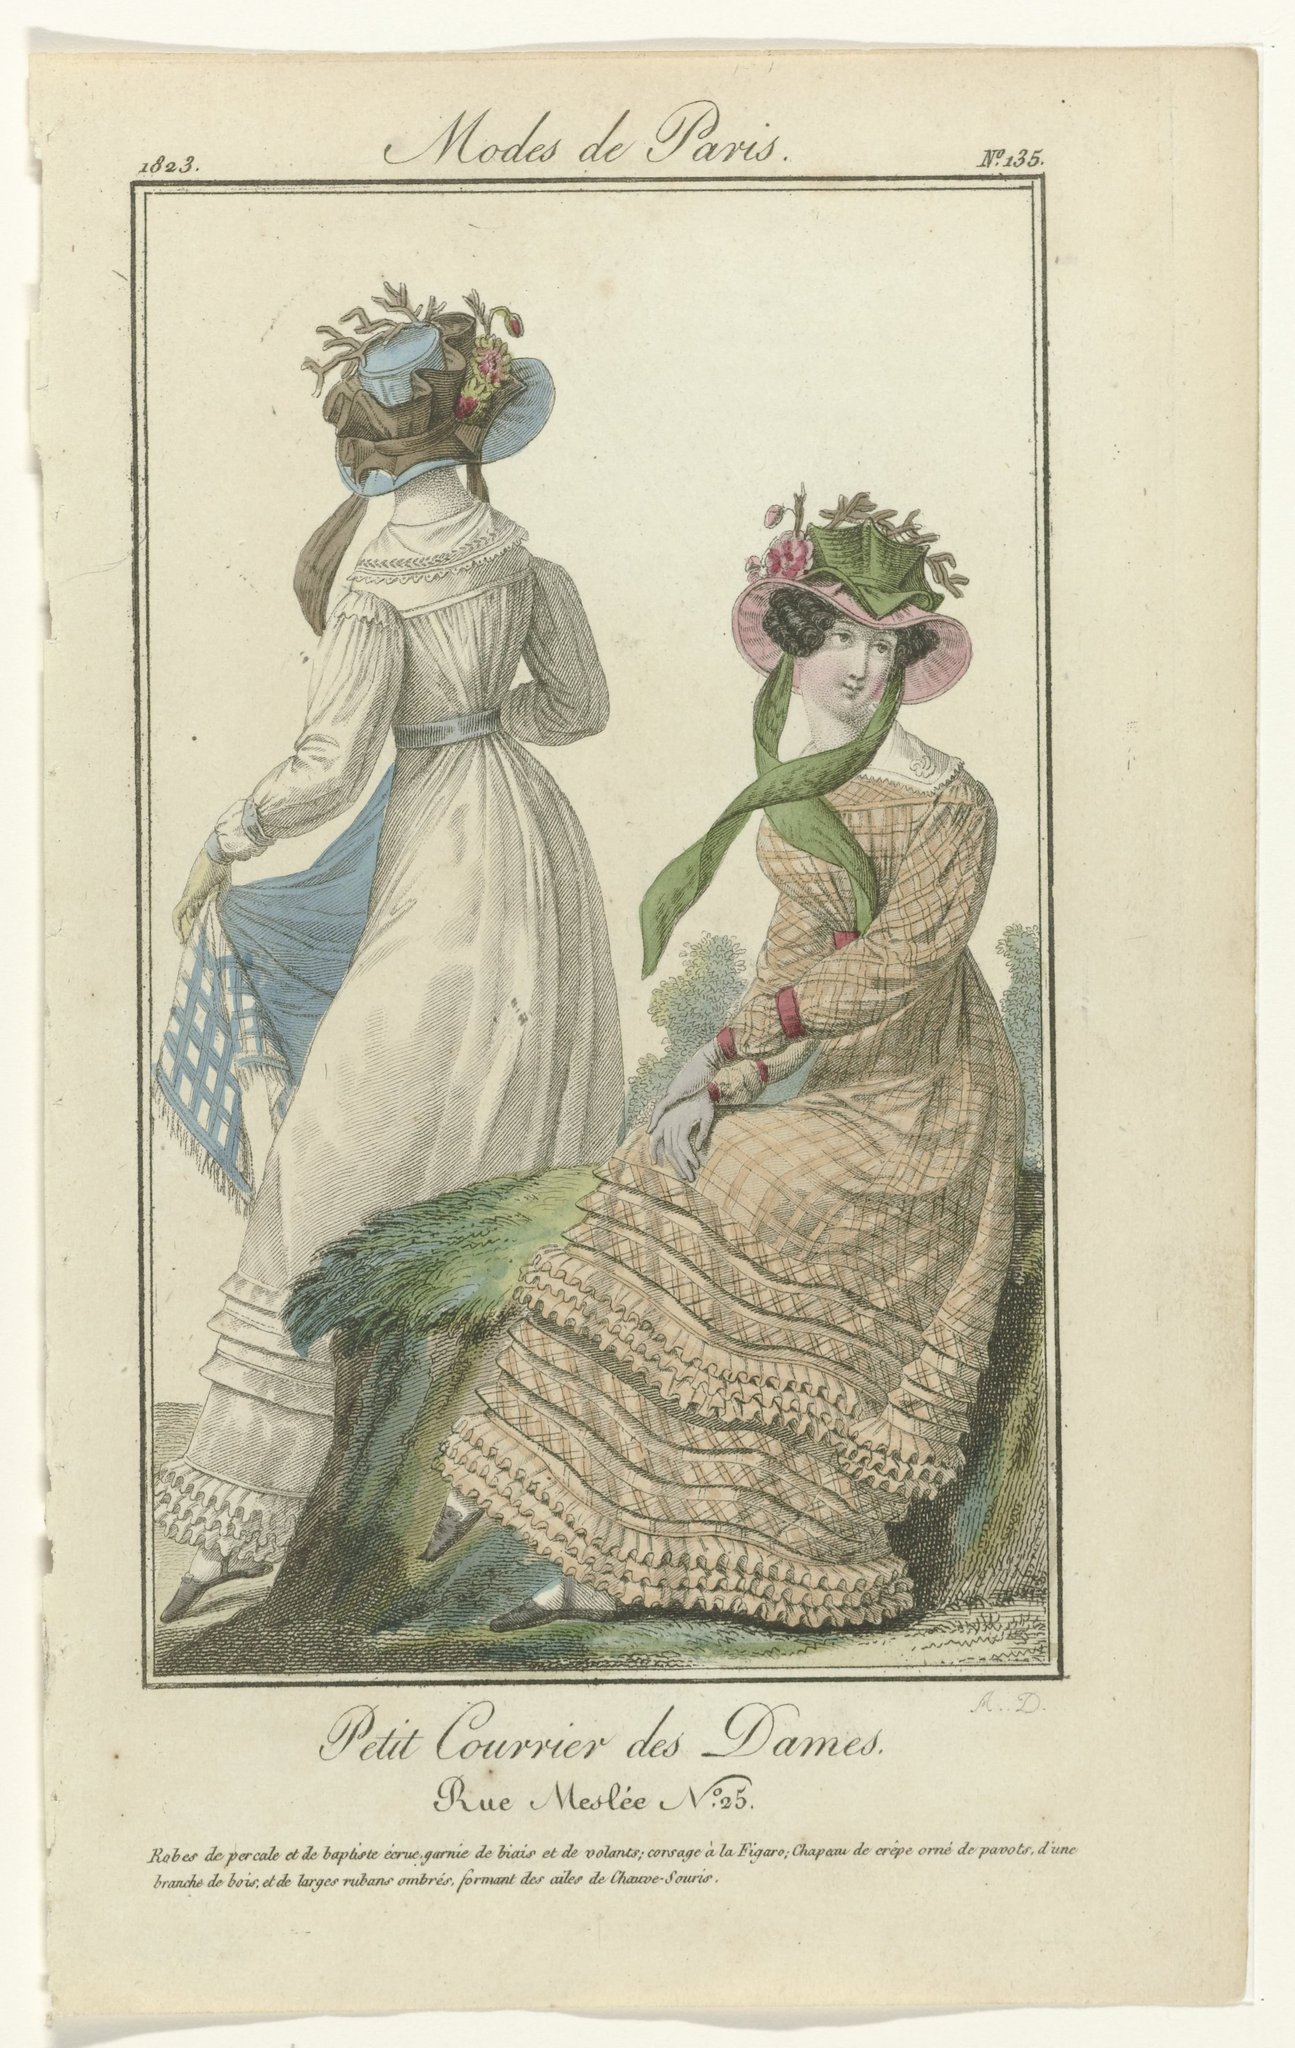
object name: fashion print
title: Petit Courrier des Dames, 1823, No. 135 : Robes de percal (...)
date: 1823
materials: paper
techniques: engraving, hand coloring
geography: paris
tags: clothing for the upper part of the body (shawl) (+ women's clothes), border, ribbon, braid (+ women's clothes), twigs ~ building material (+ variant), fashion plates, head-gear: hat (+ women's clothes), dress, gown (+ women's clothes), flowers: poppy, clothing for the upper part of the body (with name) (+ women's clothes)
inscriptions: title: ‘Petit Courrier des Dames’, title: ‘Modes de Paris’, address: ‘Rue Meslée No. 25.’, caption: ‘Robes de percale et de baptiste écru,garnie de biais et de volants; corsage à la Figare; Chapeau de crépe orné de pavots, d'une branche de bois, et de larges rubans ombrés, formant des ailes de Chauve-Souris.’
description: Twee vrouwen, van wie één op de rug gezien, in japonnen van katoenbatist (percale) en ecrukleurig batist, gegarneerd met biaisband en volants. Lijfje 'à la Figaro'. Hoed van crêpe versierd met klaprozen, een tak en brede linten. Prent uit het modetijdschrift Petit Courrier des Dames (1821-1868).